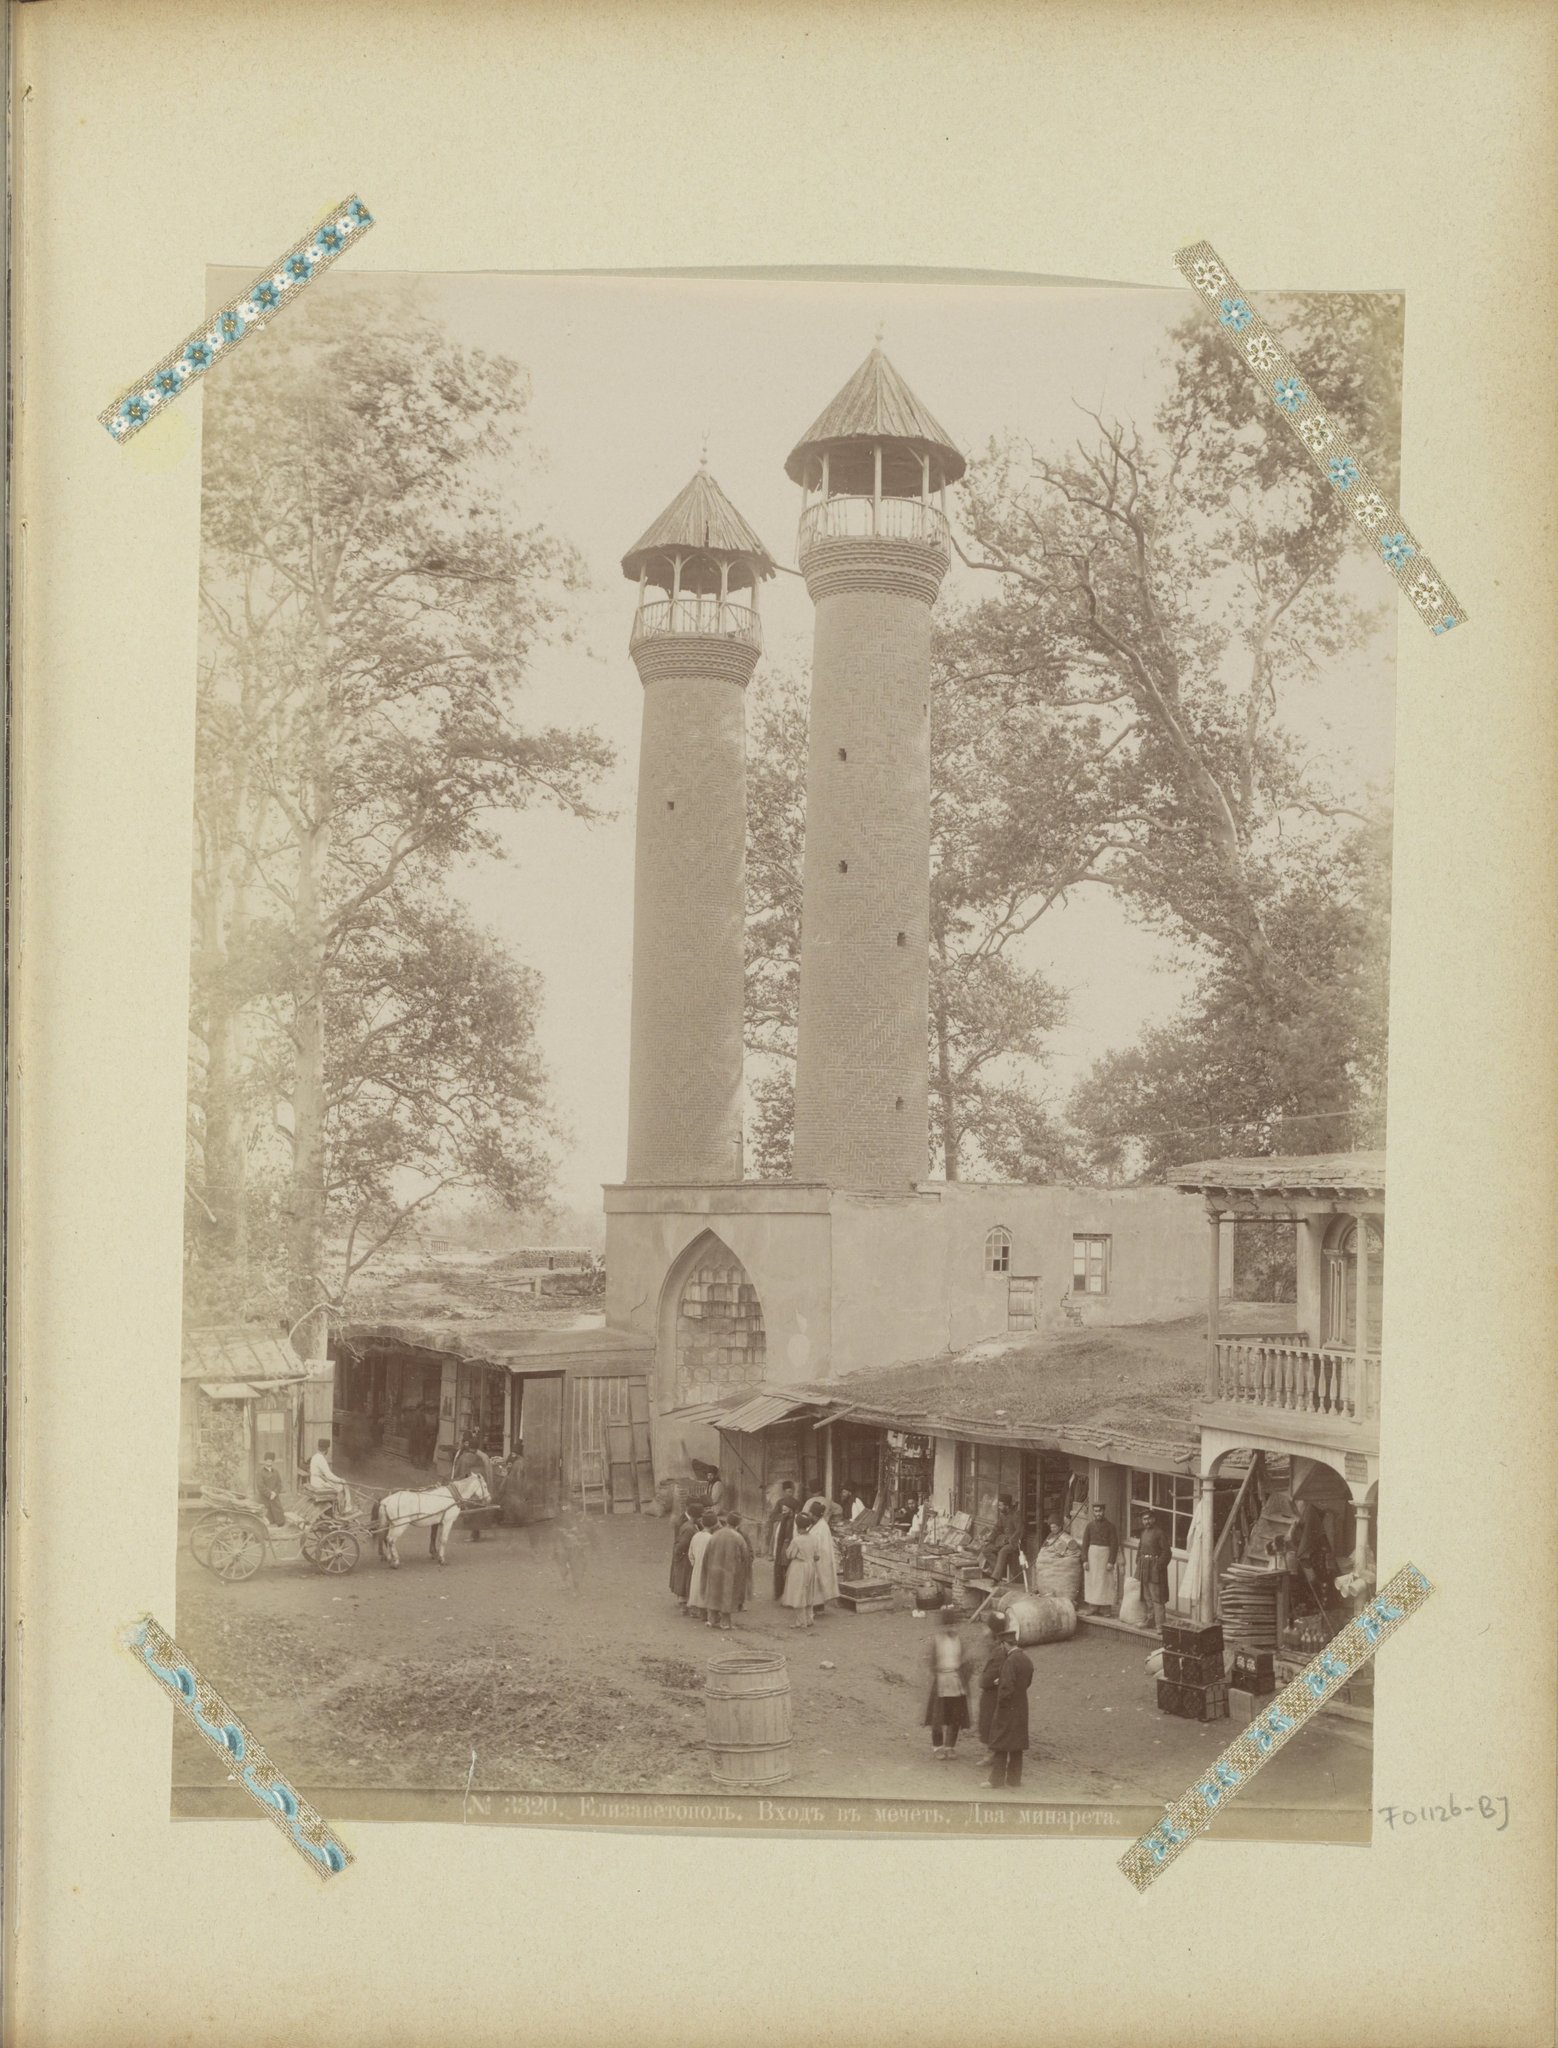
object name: photograph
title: Olizawjotonil, Wchod w mjotsot. Dwa minareta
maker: Anonymous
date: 1890-1900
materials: photographic support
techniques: albumen print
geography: caucasus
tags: temple, shrine ~ islam, mohammedanism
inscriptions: number: ‘3320’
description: Onderdeel van Fotoalbum met opnames van bezienswaardigheden in Georgië, Sint-Petersburg en Moskou.